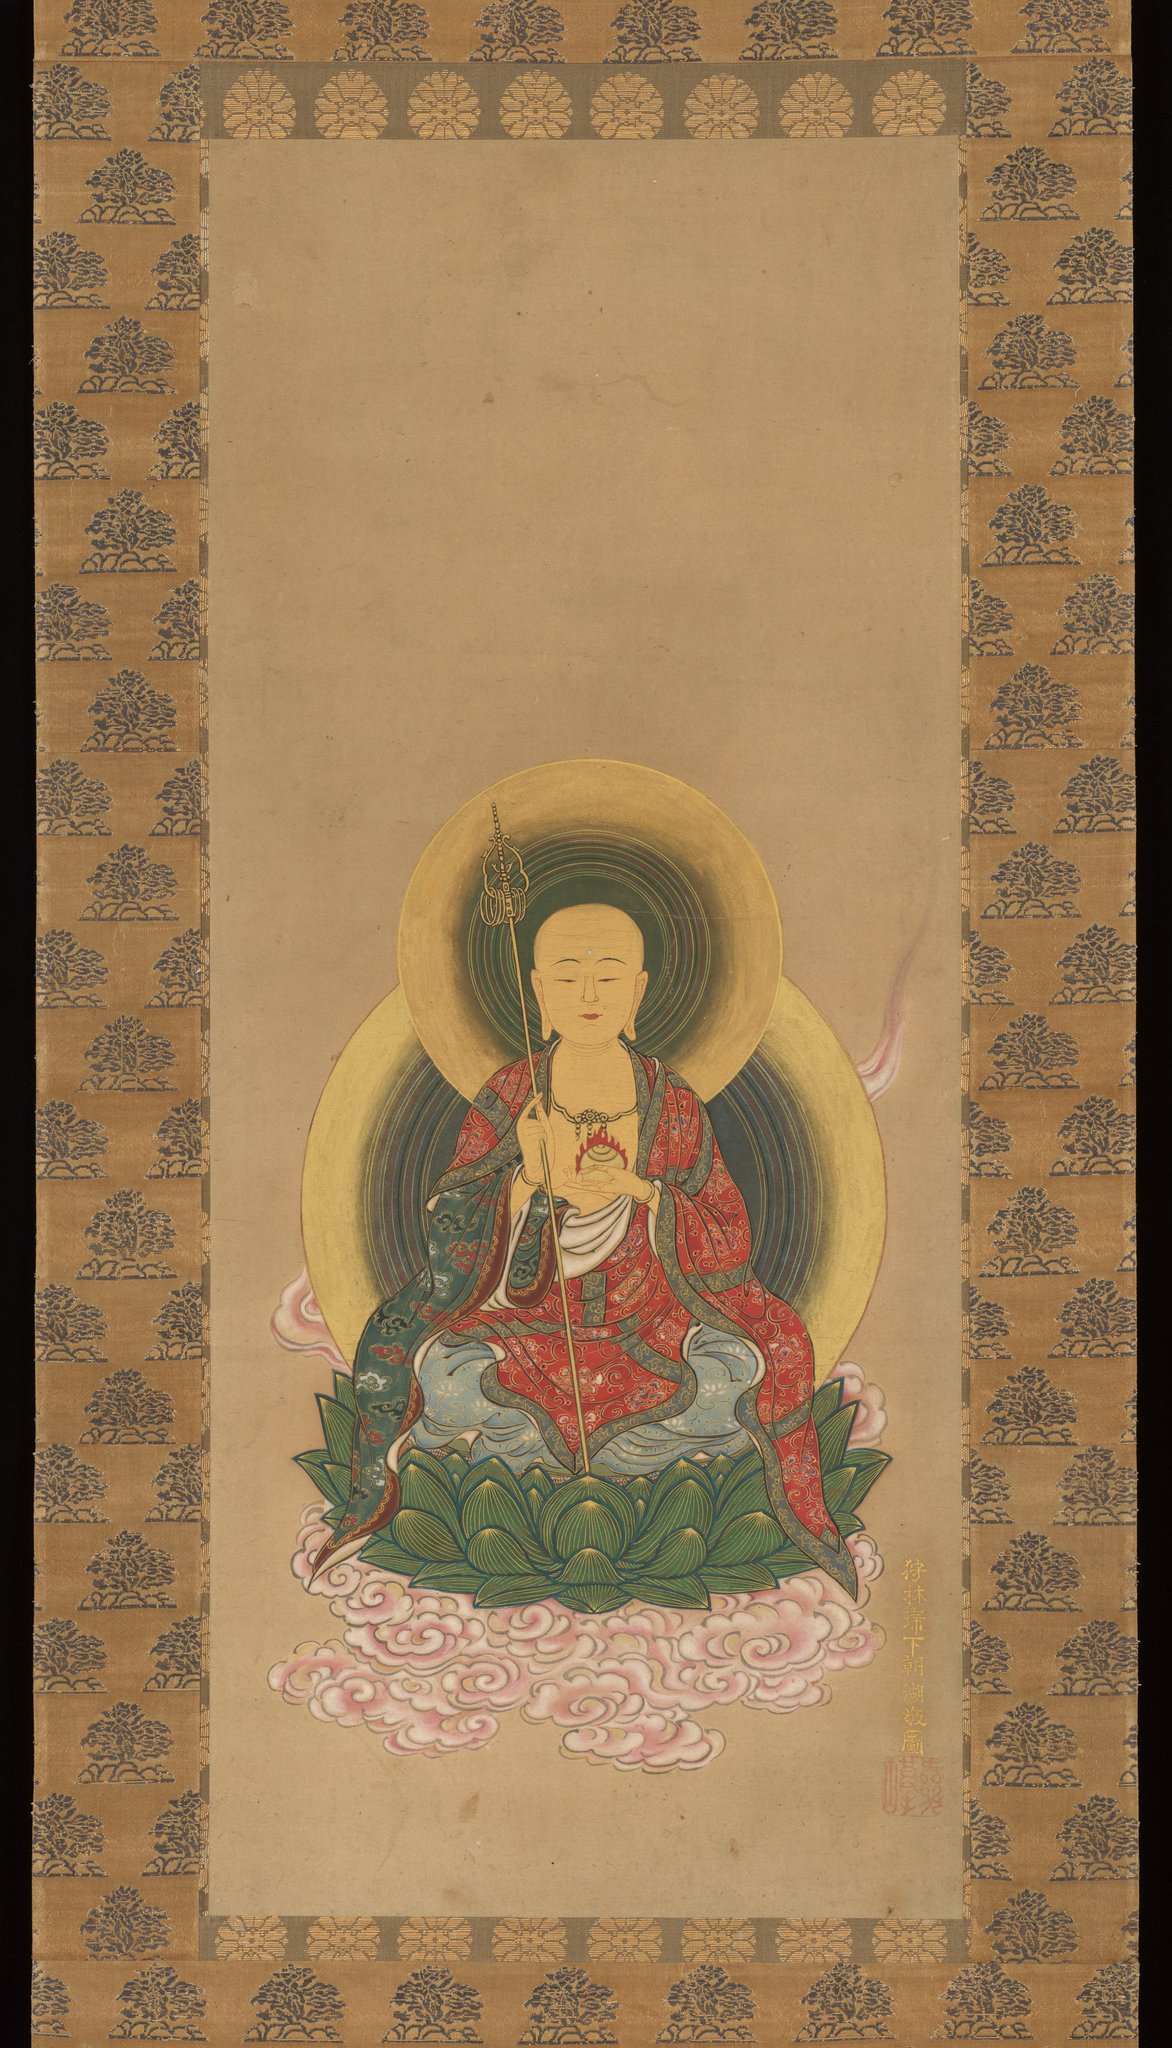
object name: hanging scroll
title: Jizō Bosatsu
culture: japanese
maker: hanabusa itchō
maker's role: artist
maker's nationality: japanese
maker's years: 1652-1724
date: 1667-1698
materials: gold paint, ink, paper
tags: bodhisattvas